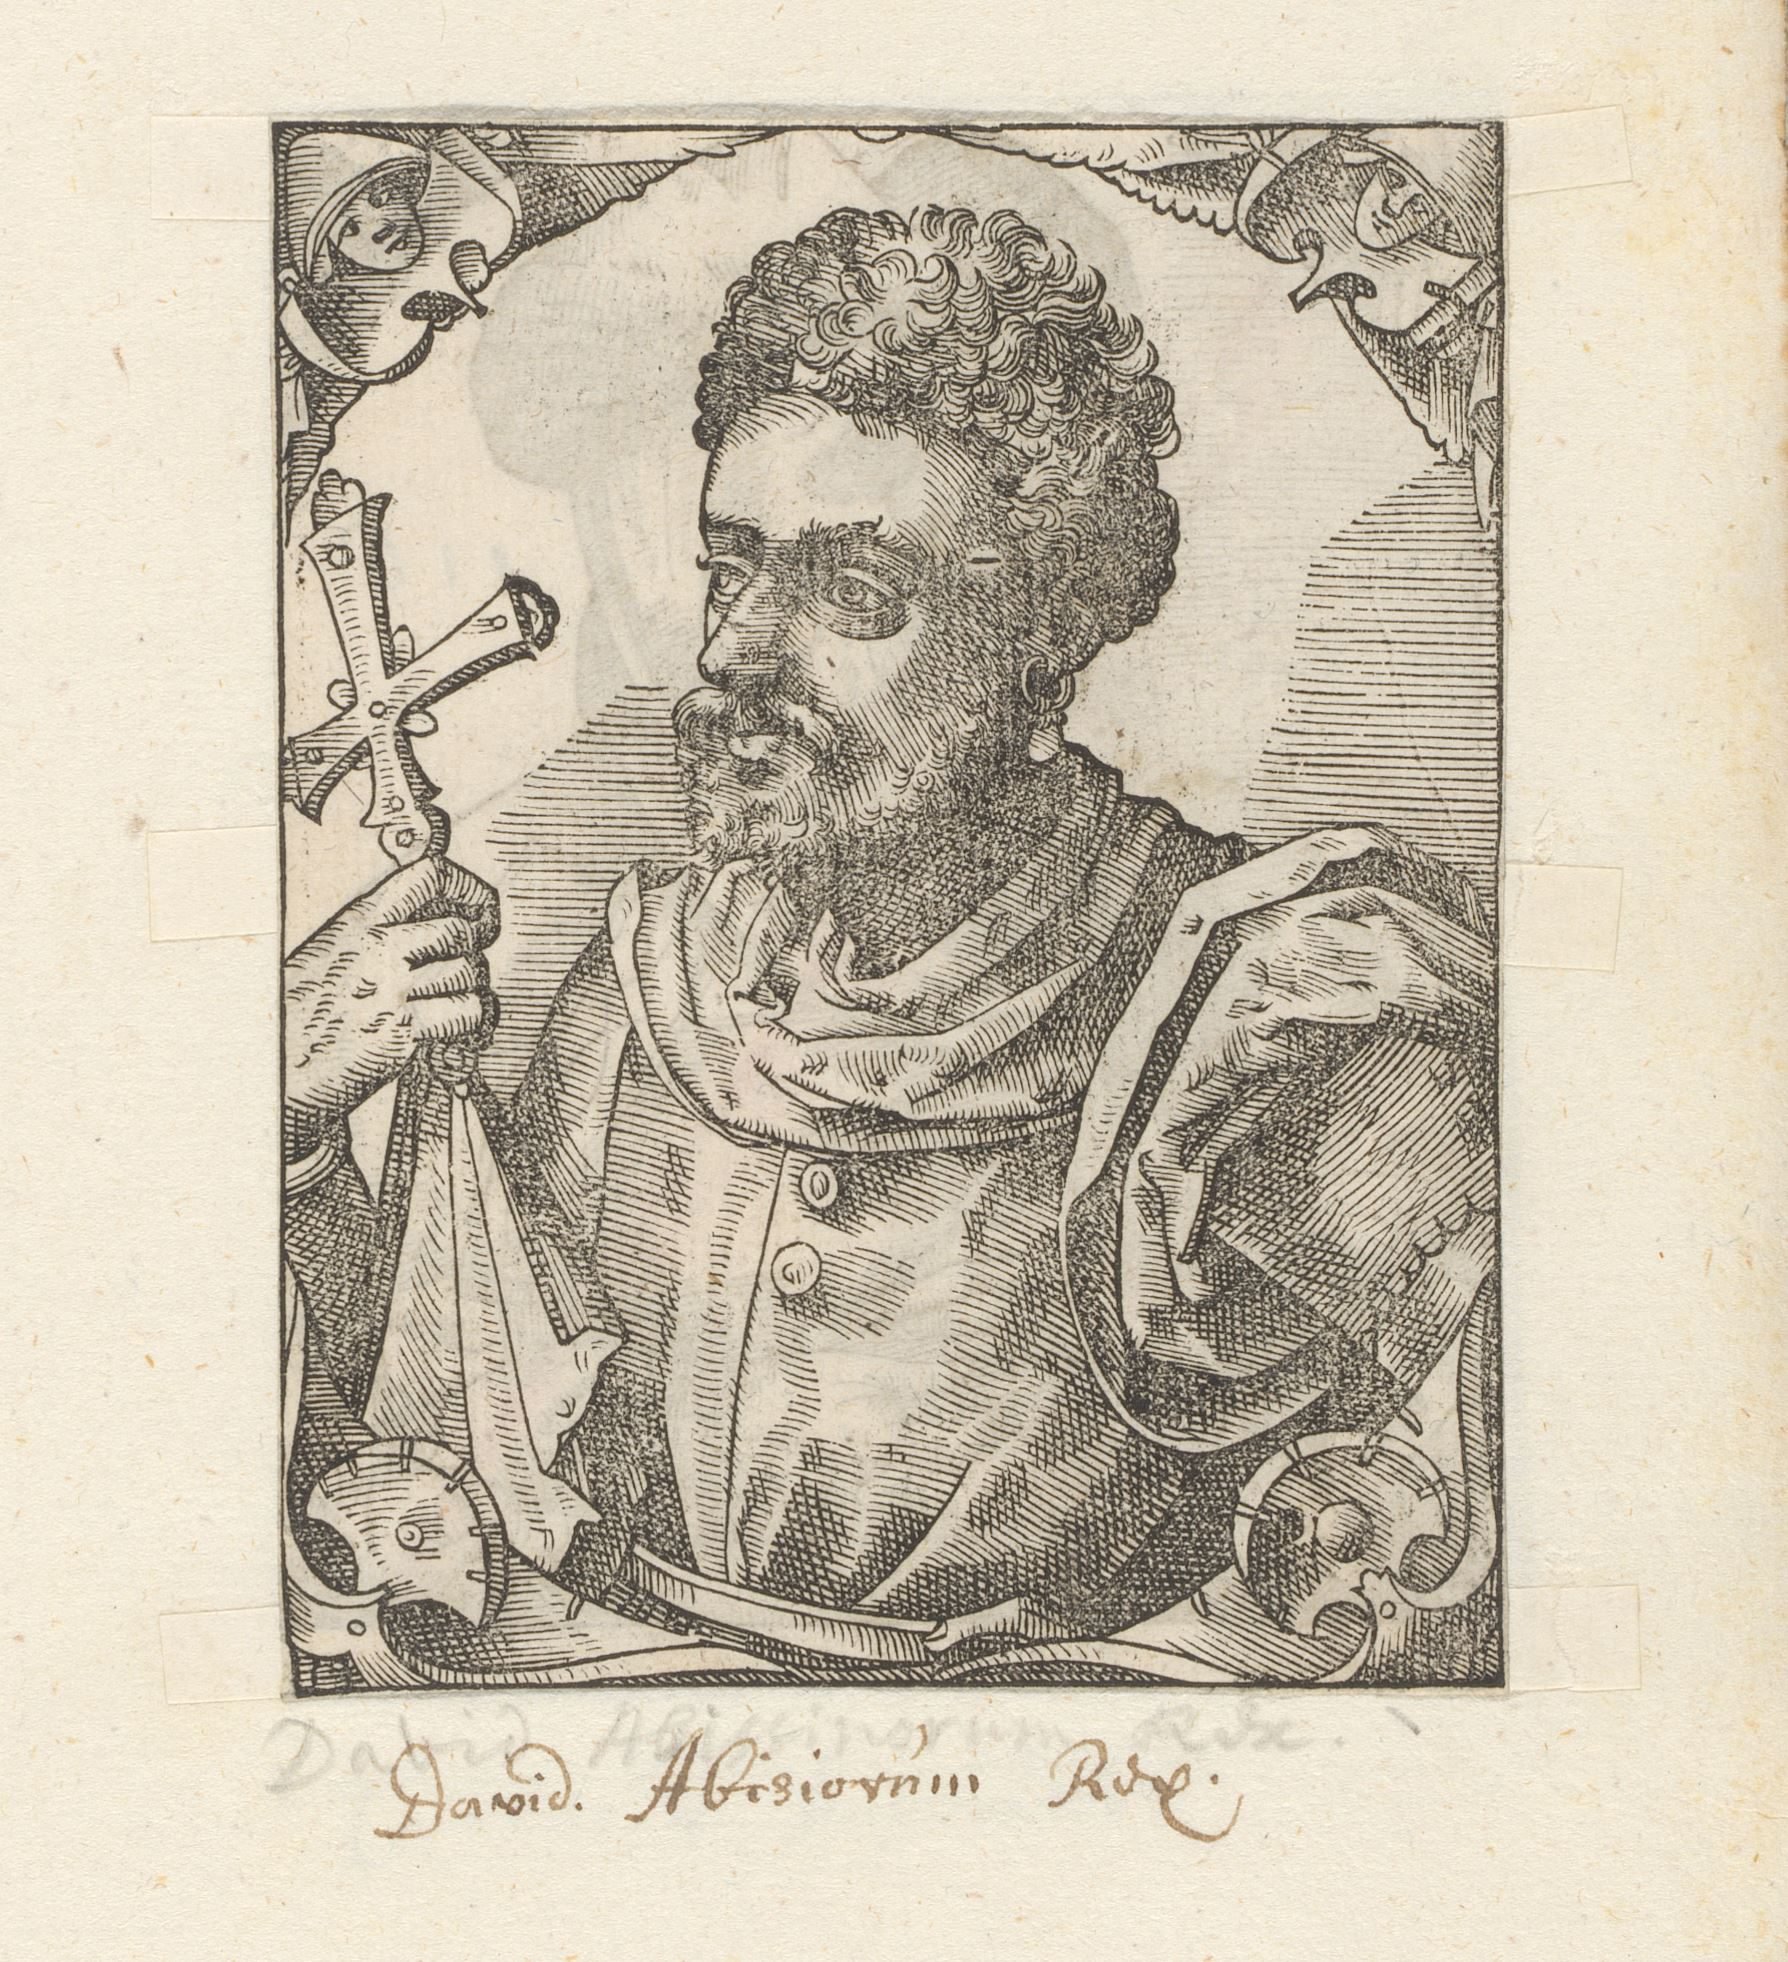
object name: book illustration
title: Portret van Dawit II, keizer van Abessinië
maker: Anonymous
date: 1549-1575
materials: paper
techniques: woodcut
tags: historical persons, ruler, sovereign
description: Prent gebruikt in: Giovio, Paolo. Elogia Virorum bellica virtute illustrium (...). Bazel: Peter Perna, 1575.